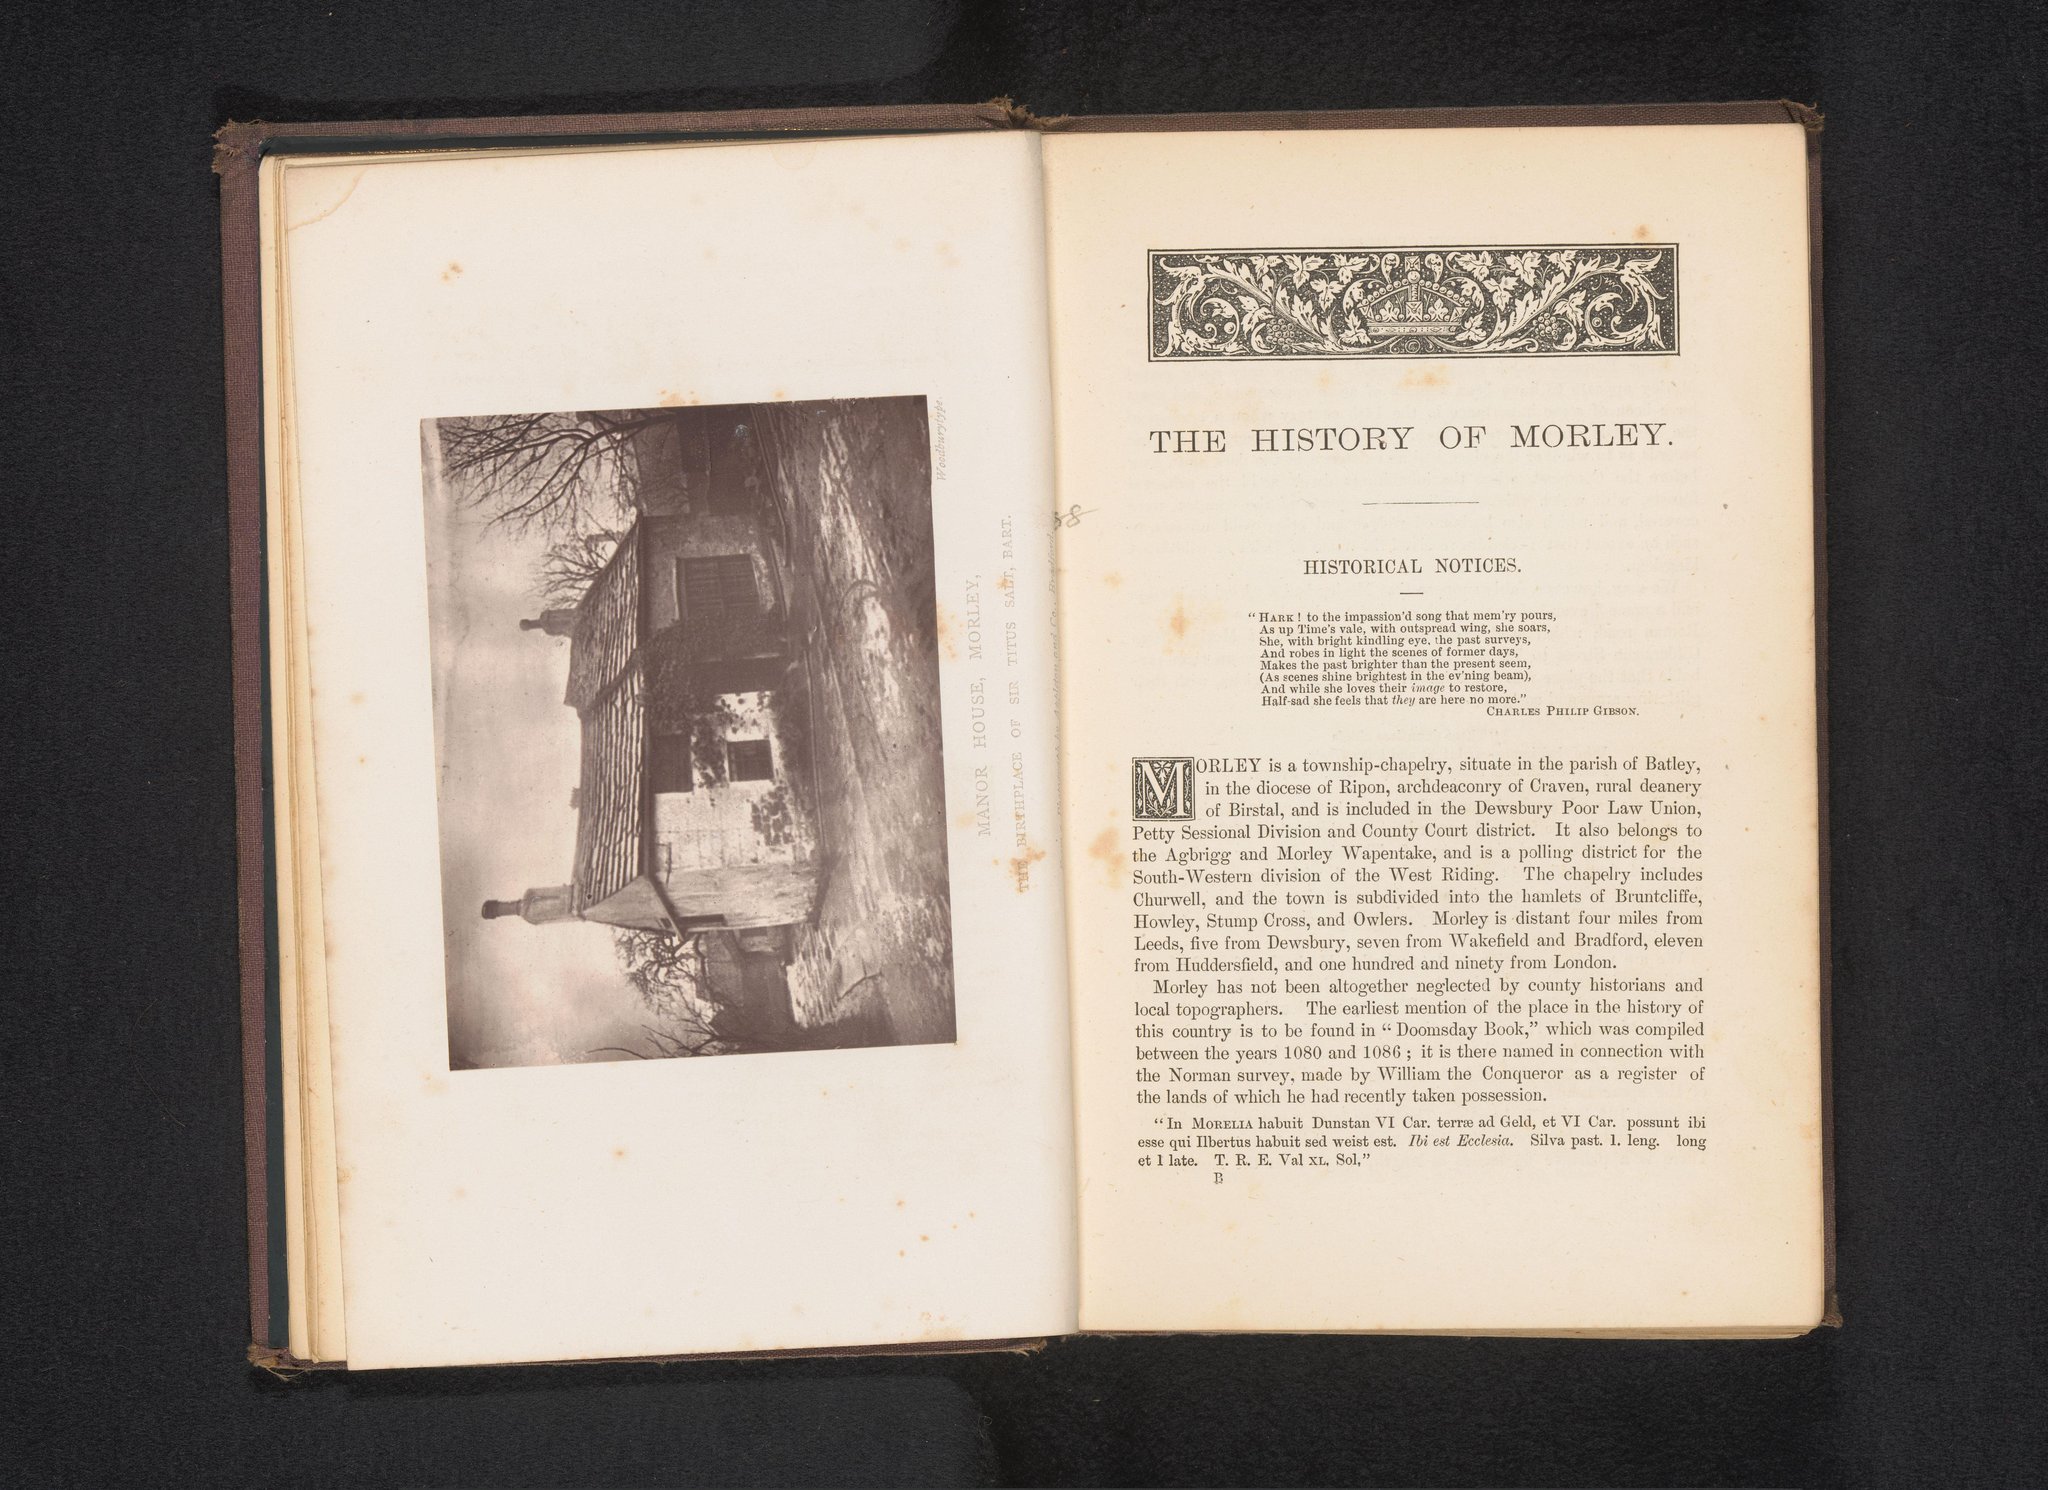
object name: page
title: Manor House, Morley, the Birthplace of Sir Titus Salt, Bart.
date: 1871-1876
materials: paper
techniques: woodburytype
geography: morley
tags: politician, country-house